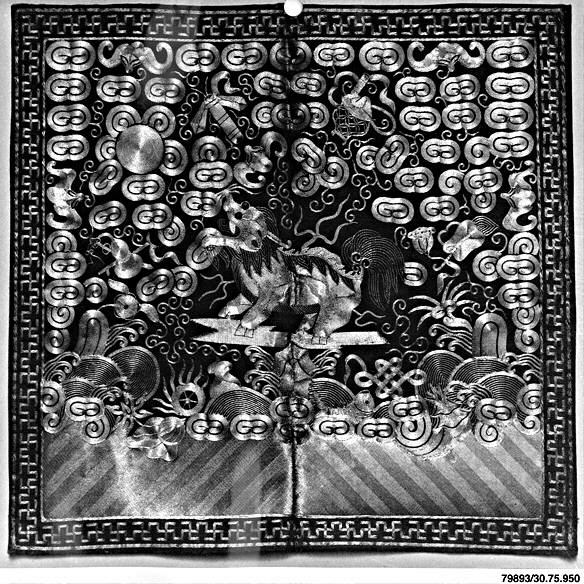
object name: rank badge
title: Rank Badge with Qilin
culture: chinese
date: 1801-1900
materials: metal thread, silk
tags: bats,mythical creatures